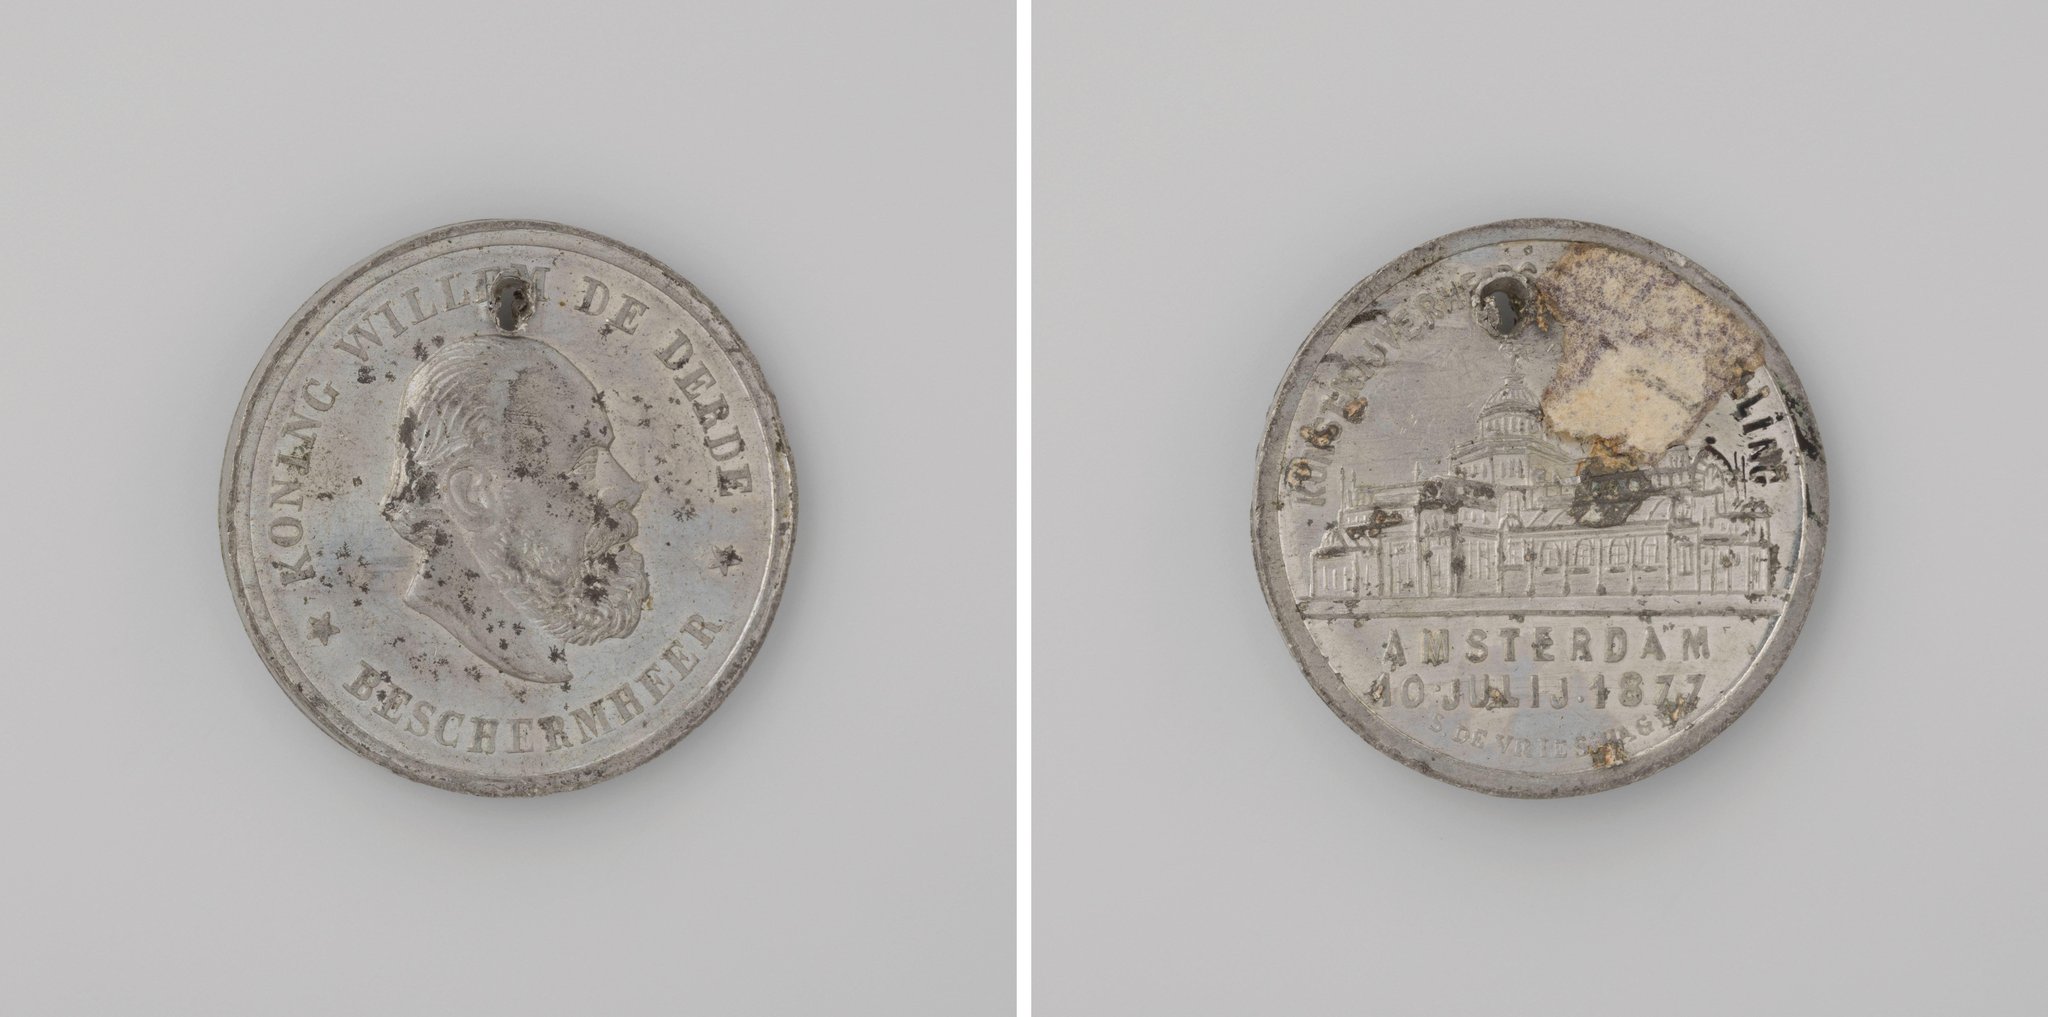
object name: history medal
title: Internationale tentoonstelling van Kunstnijverheid in het Paleis voor Volksvlijt te Amsterdam 1877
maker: salomon de vries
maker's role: graveur, medailleur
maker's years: 1830-1899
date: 1877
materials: aluminum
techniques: striking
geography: the hague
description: Tinnen penning met doorboring, op de voorzijde het portret van Koning Willem III naar rechts met omschrift, op de keerzijde het aanzicht van het Paleis van Volksvlijt met omschrift en afsnedetekst.